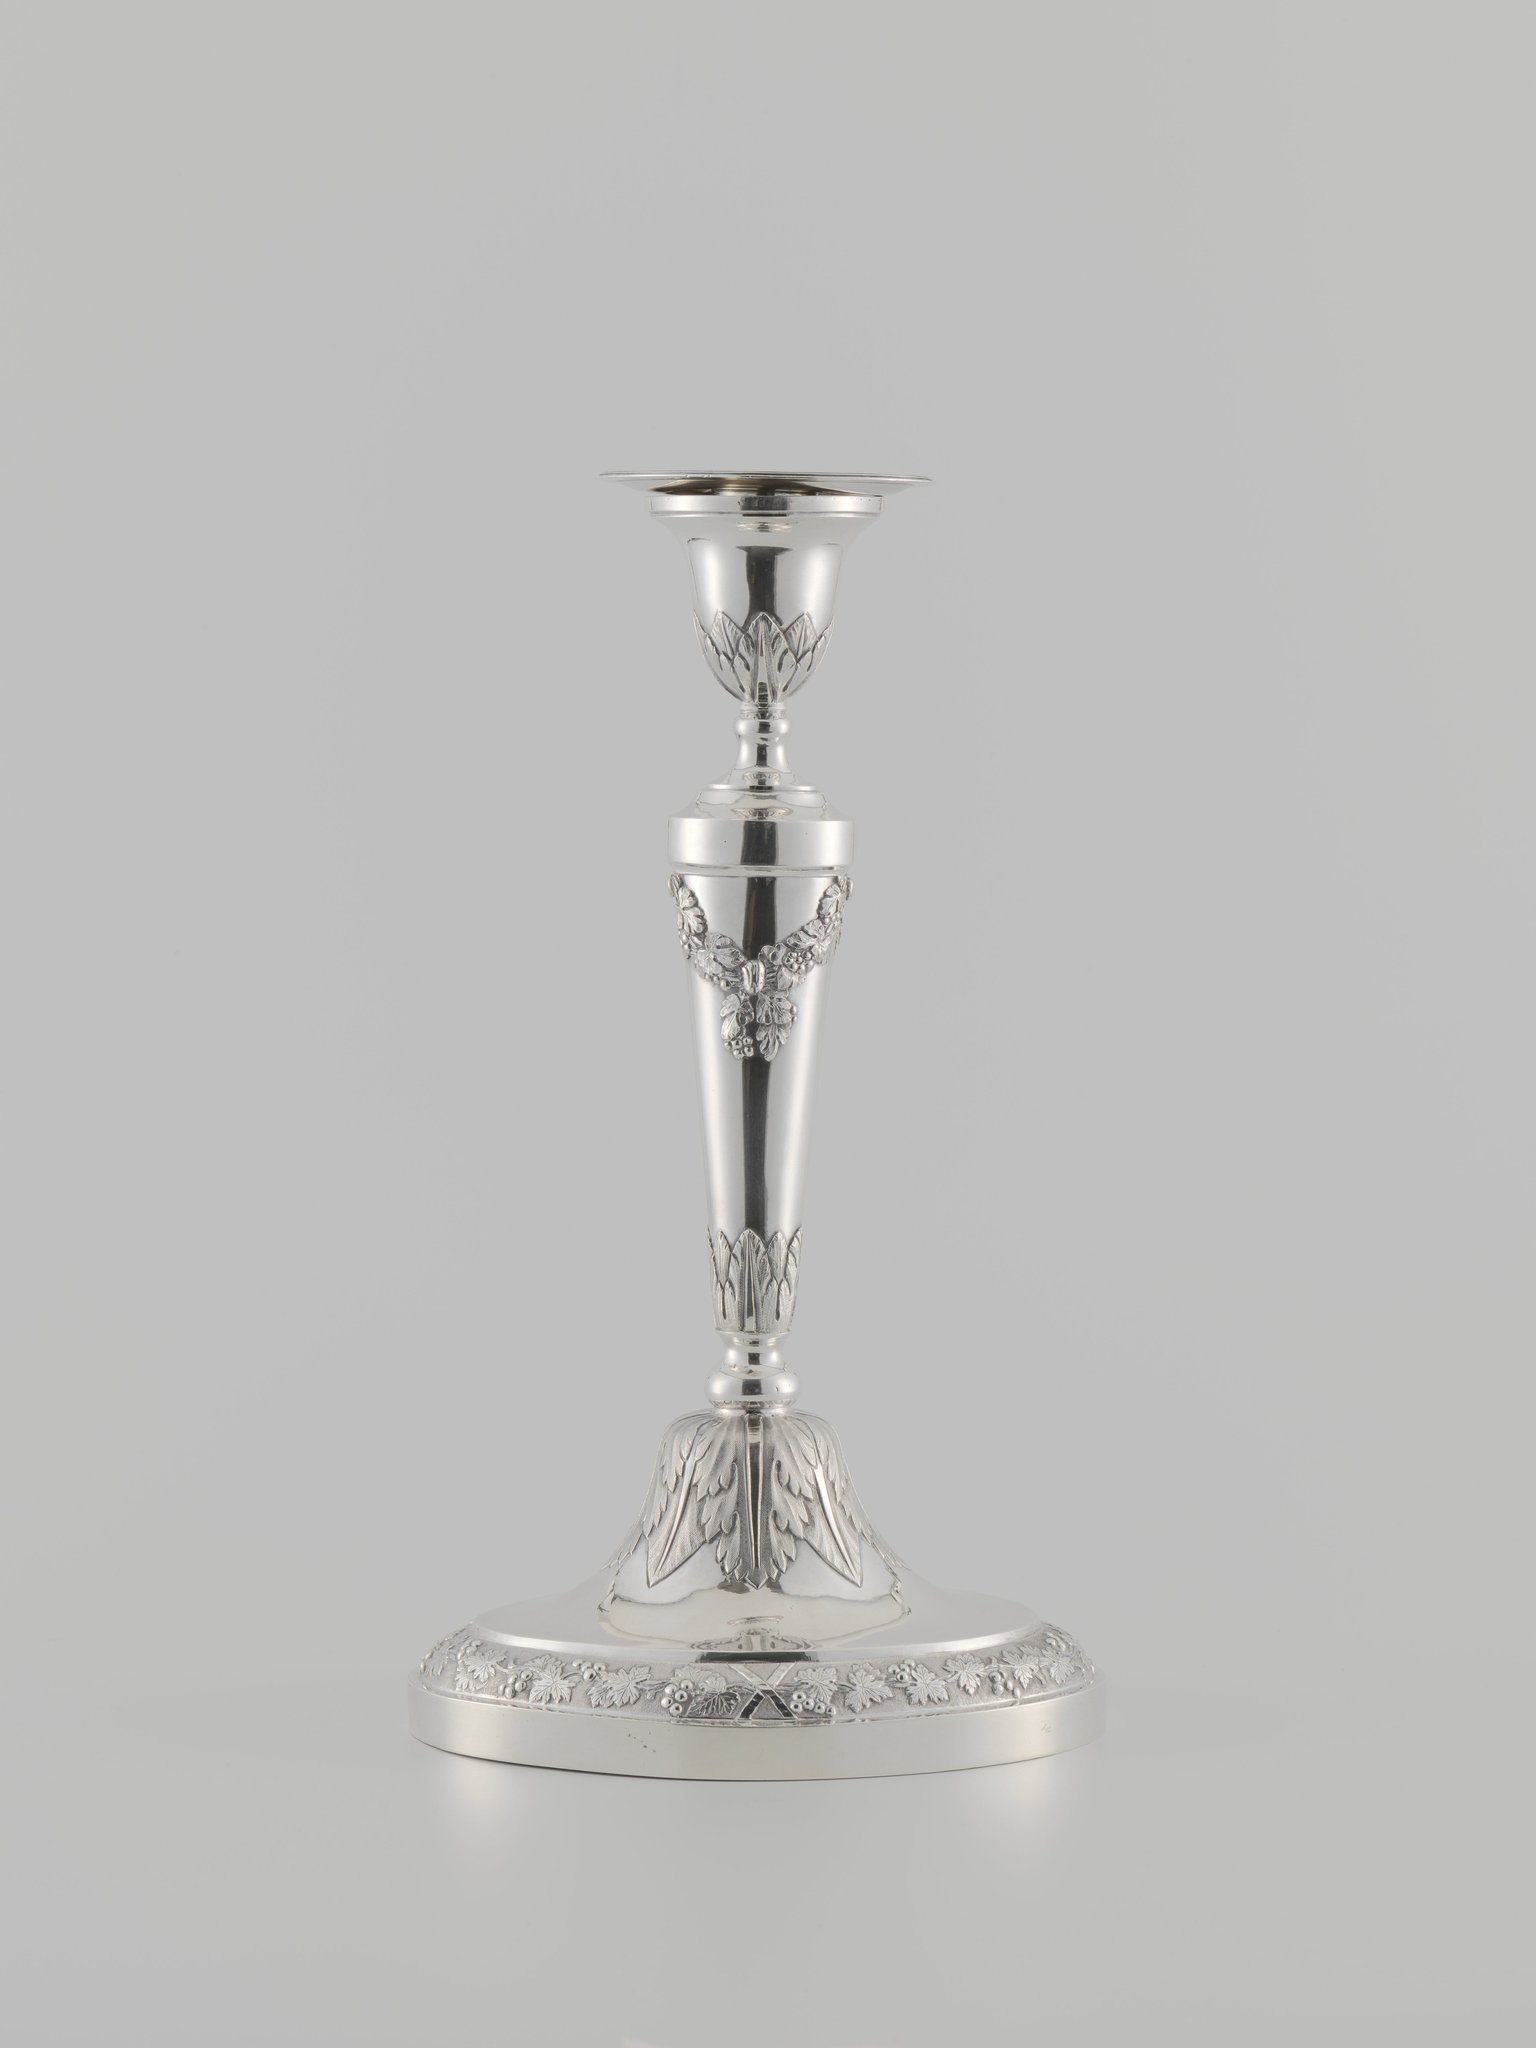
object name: candlestick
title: Kandelaar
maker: francois marcus simons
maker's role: silversmith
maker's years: 1750-1828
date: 1803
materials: silver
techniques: casting, metalworking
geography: the hague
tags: vine, foliage ~ ornament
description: Dinner service. Silver, parcel gilt. The Hague, 1803 and 1804, by François Simons. The Government of the Batavian Republic presented this service to I.J.A. Gogel (1765 - 1821) in 1804 in recognition of his financial services to the country. Gogel was a prominent patriot, minister of finance under King Louis Napoleon and subsequently financial advisor to King